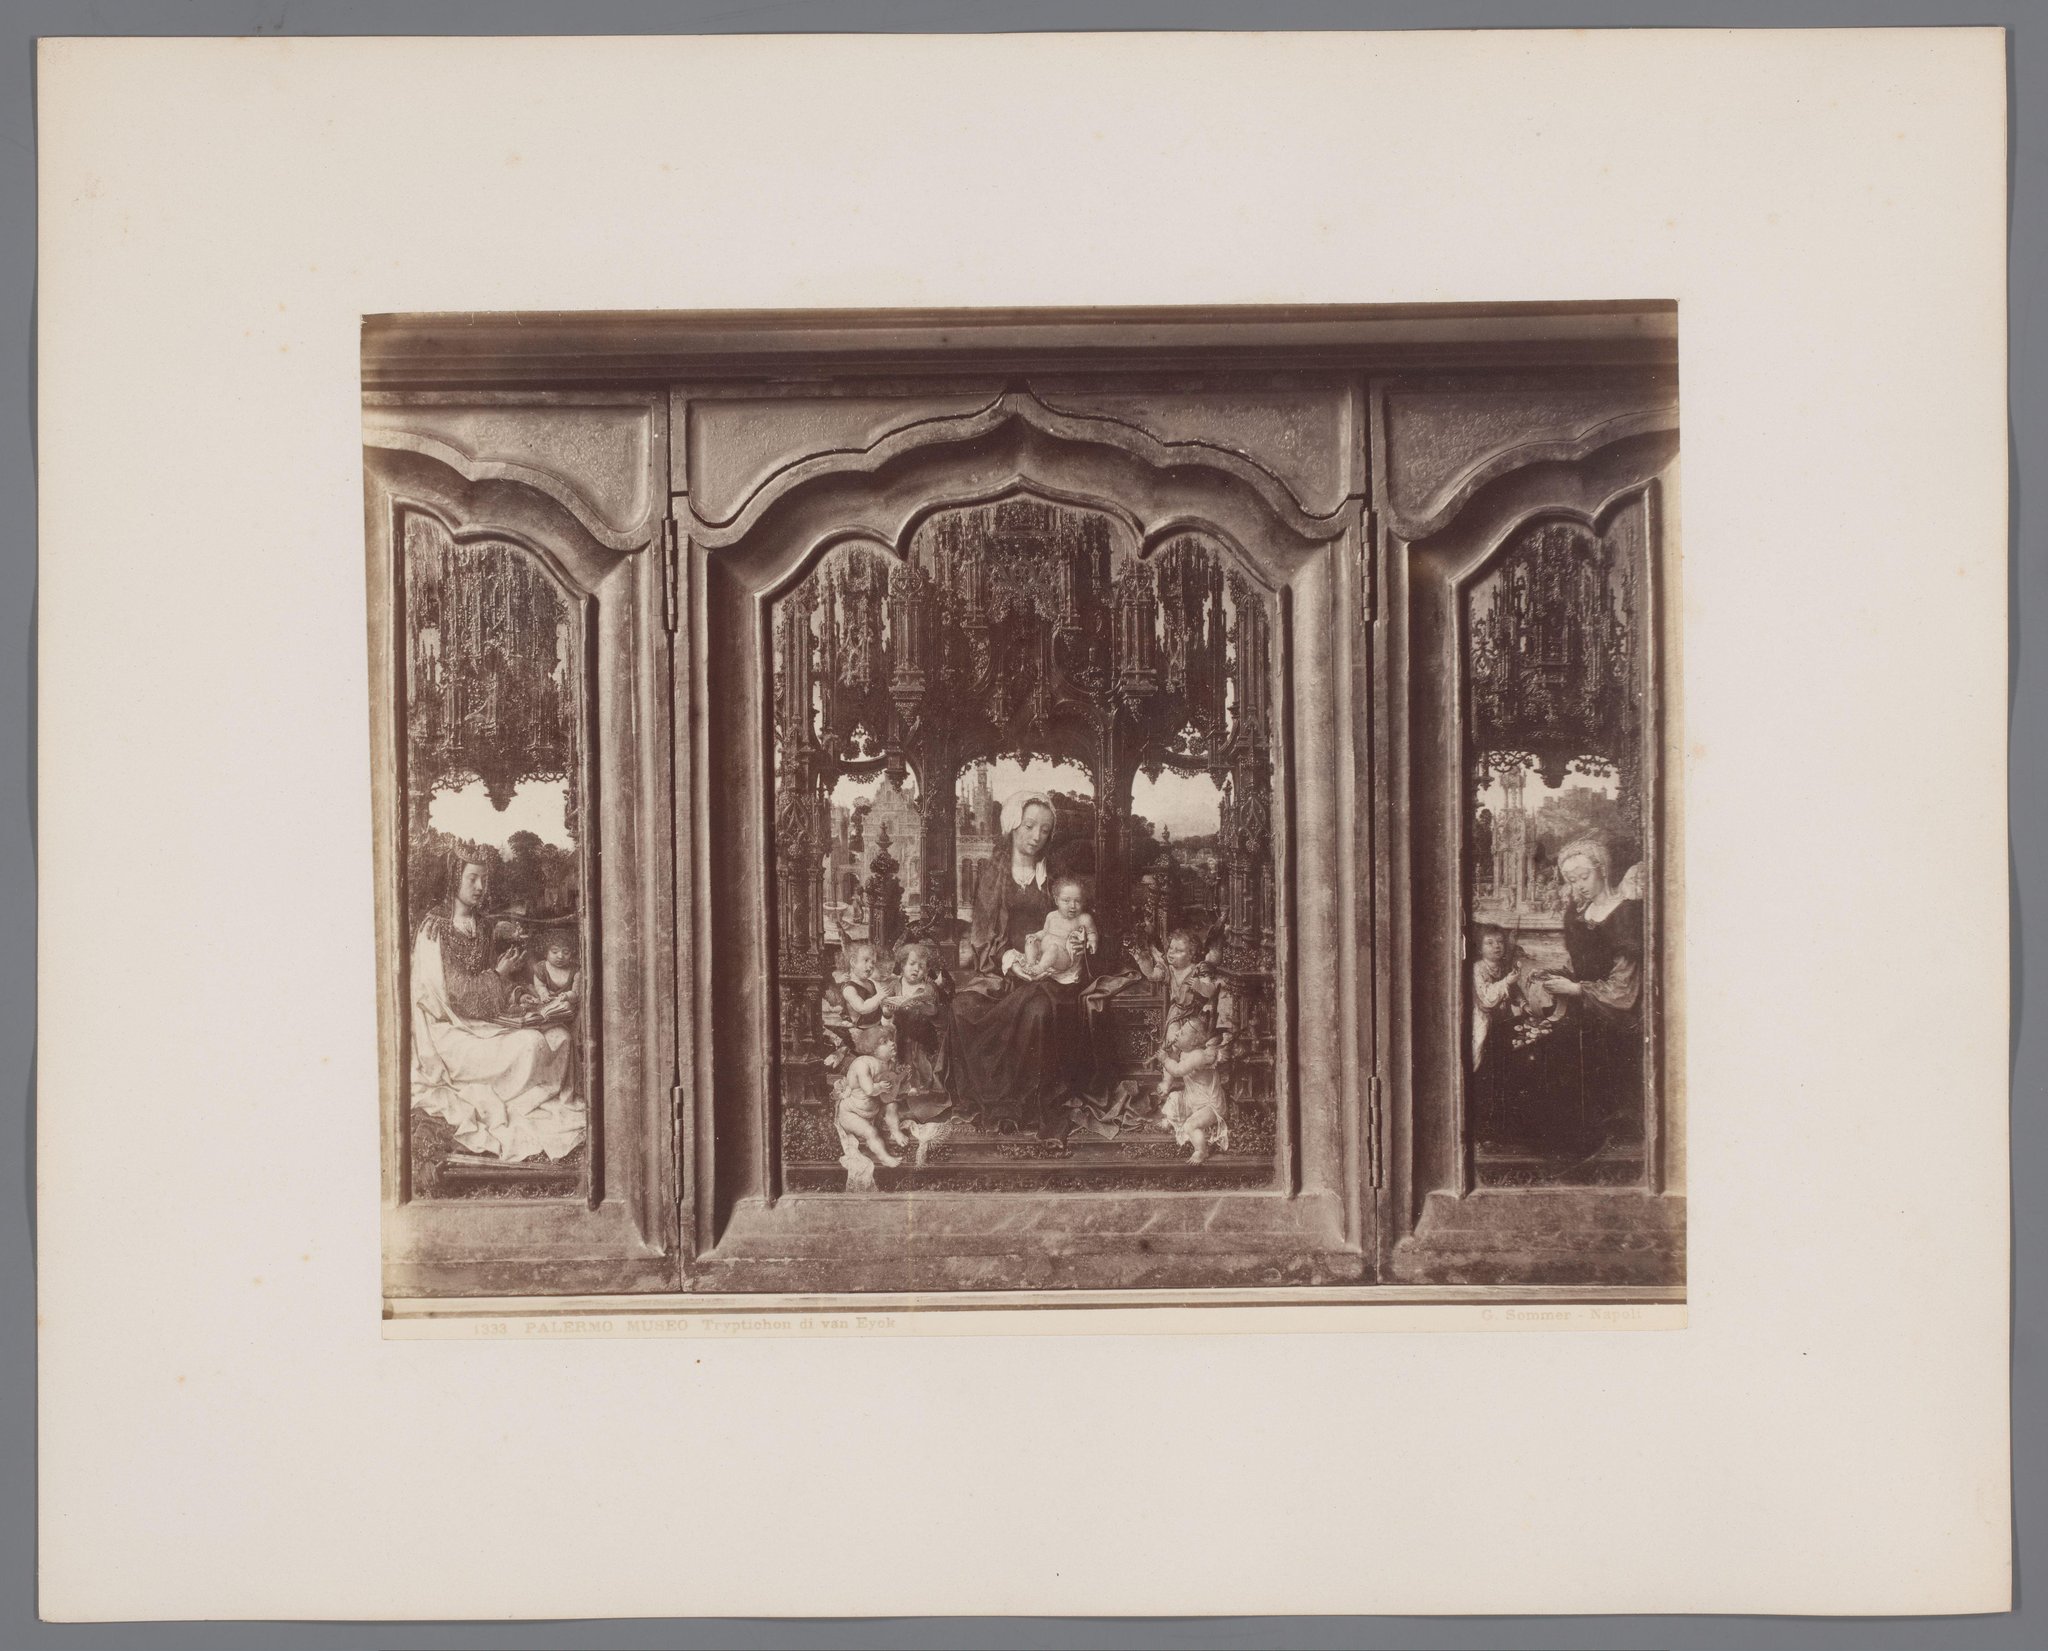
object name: photograph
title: Tryptichon di van Eyck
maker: giorgio sommer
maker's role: fotograaf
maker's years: 1834-1914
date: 1857-1914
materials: cardboard, paper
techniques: albumen print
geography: palermo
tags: picture, painting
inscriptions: number: ‘1333’